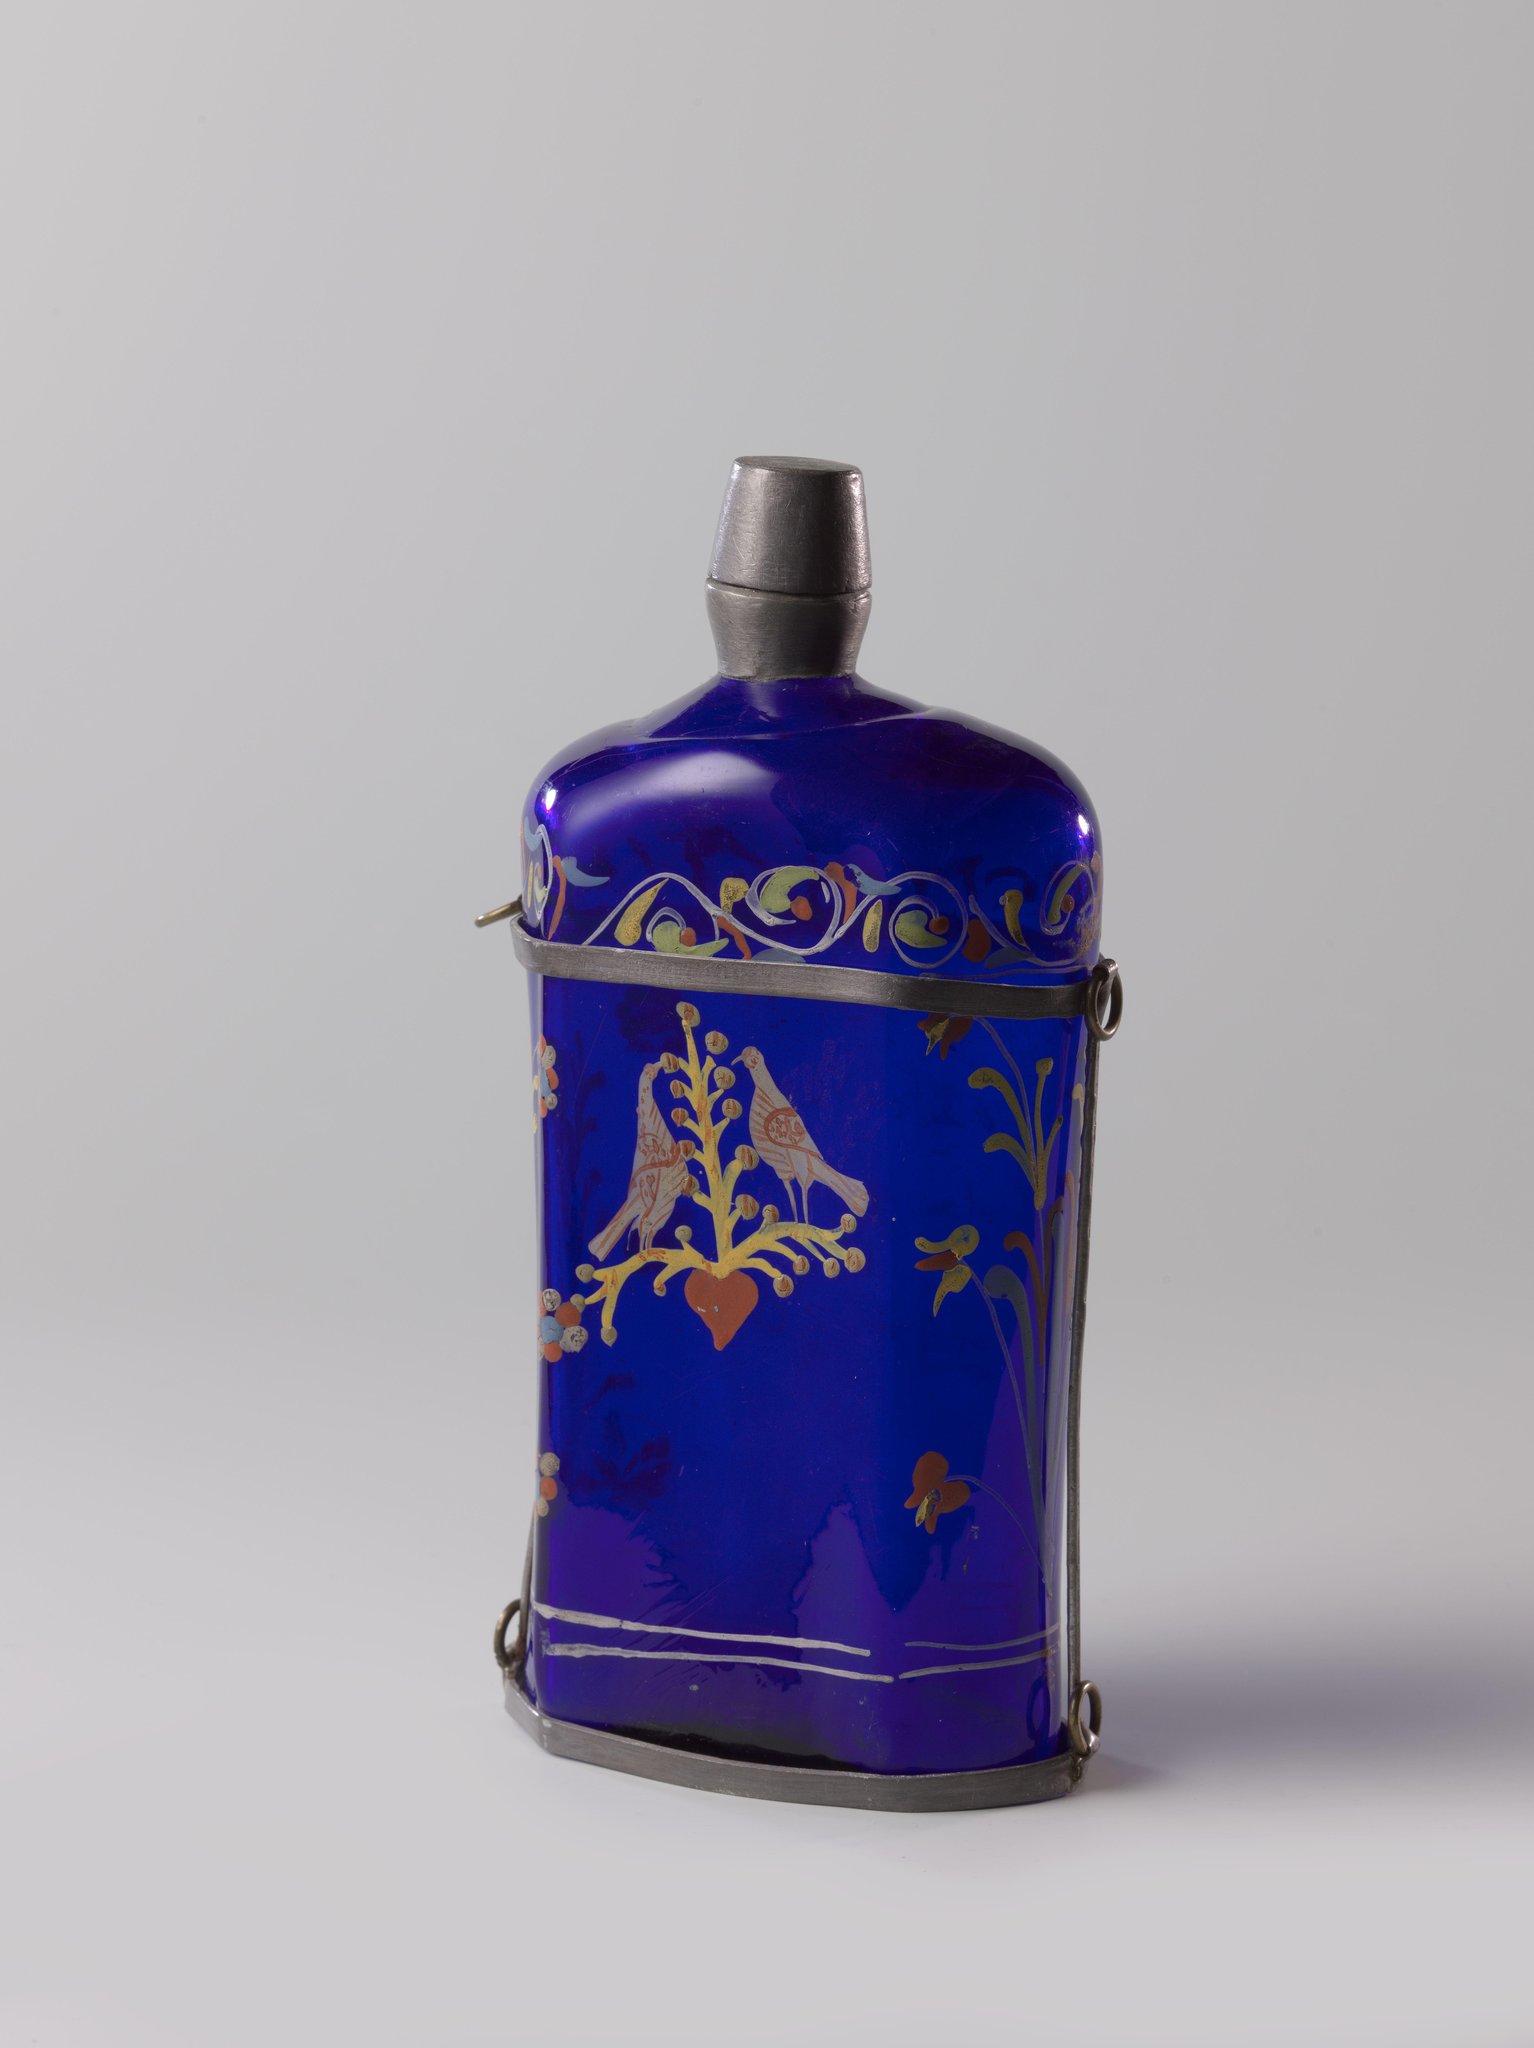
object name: bottle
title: Tinnen montuur van zeskantige fles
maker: Anonymous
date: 1730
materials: glass, tin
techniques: glassblowing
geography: central europe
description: De hals gevat in een tinnen montuur. Gladde, tinnen schroefdop.